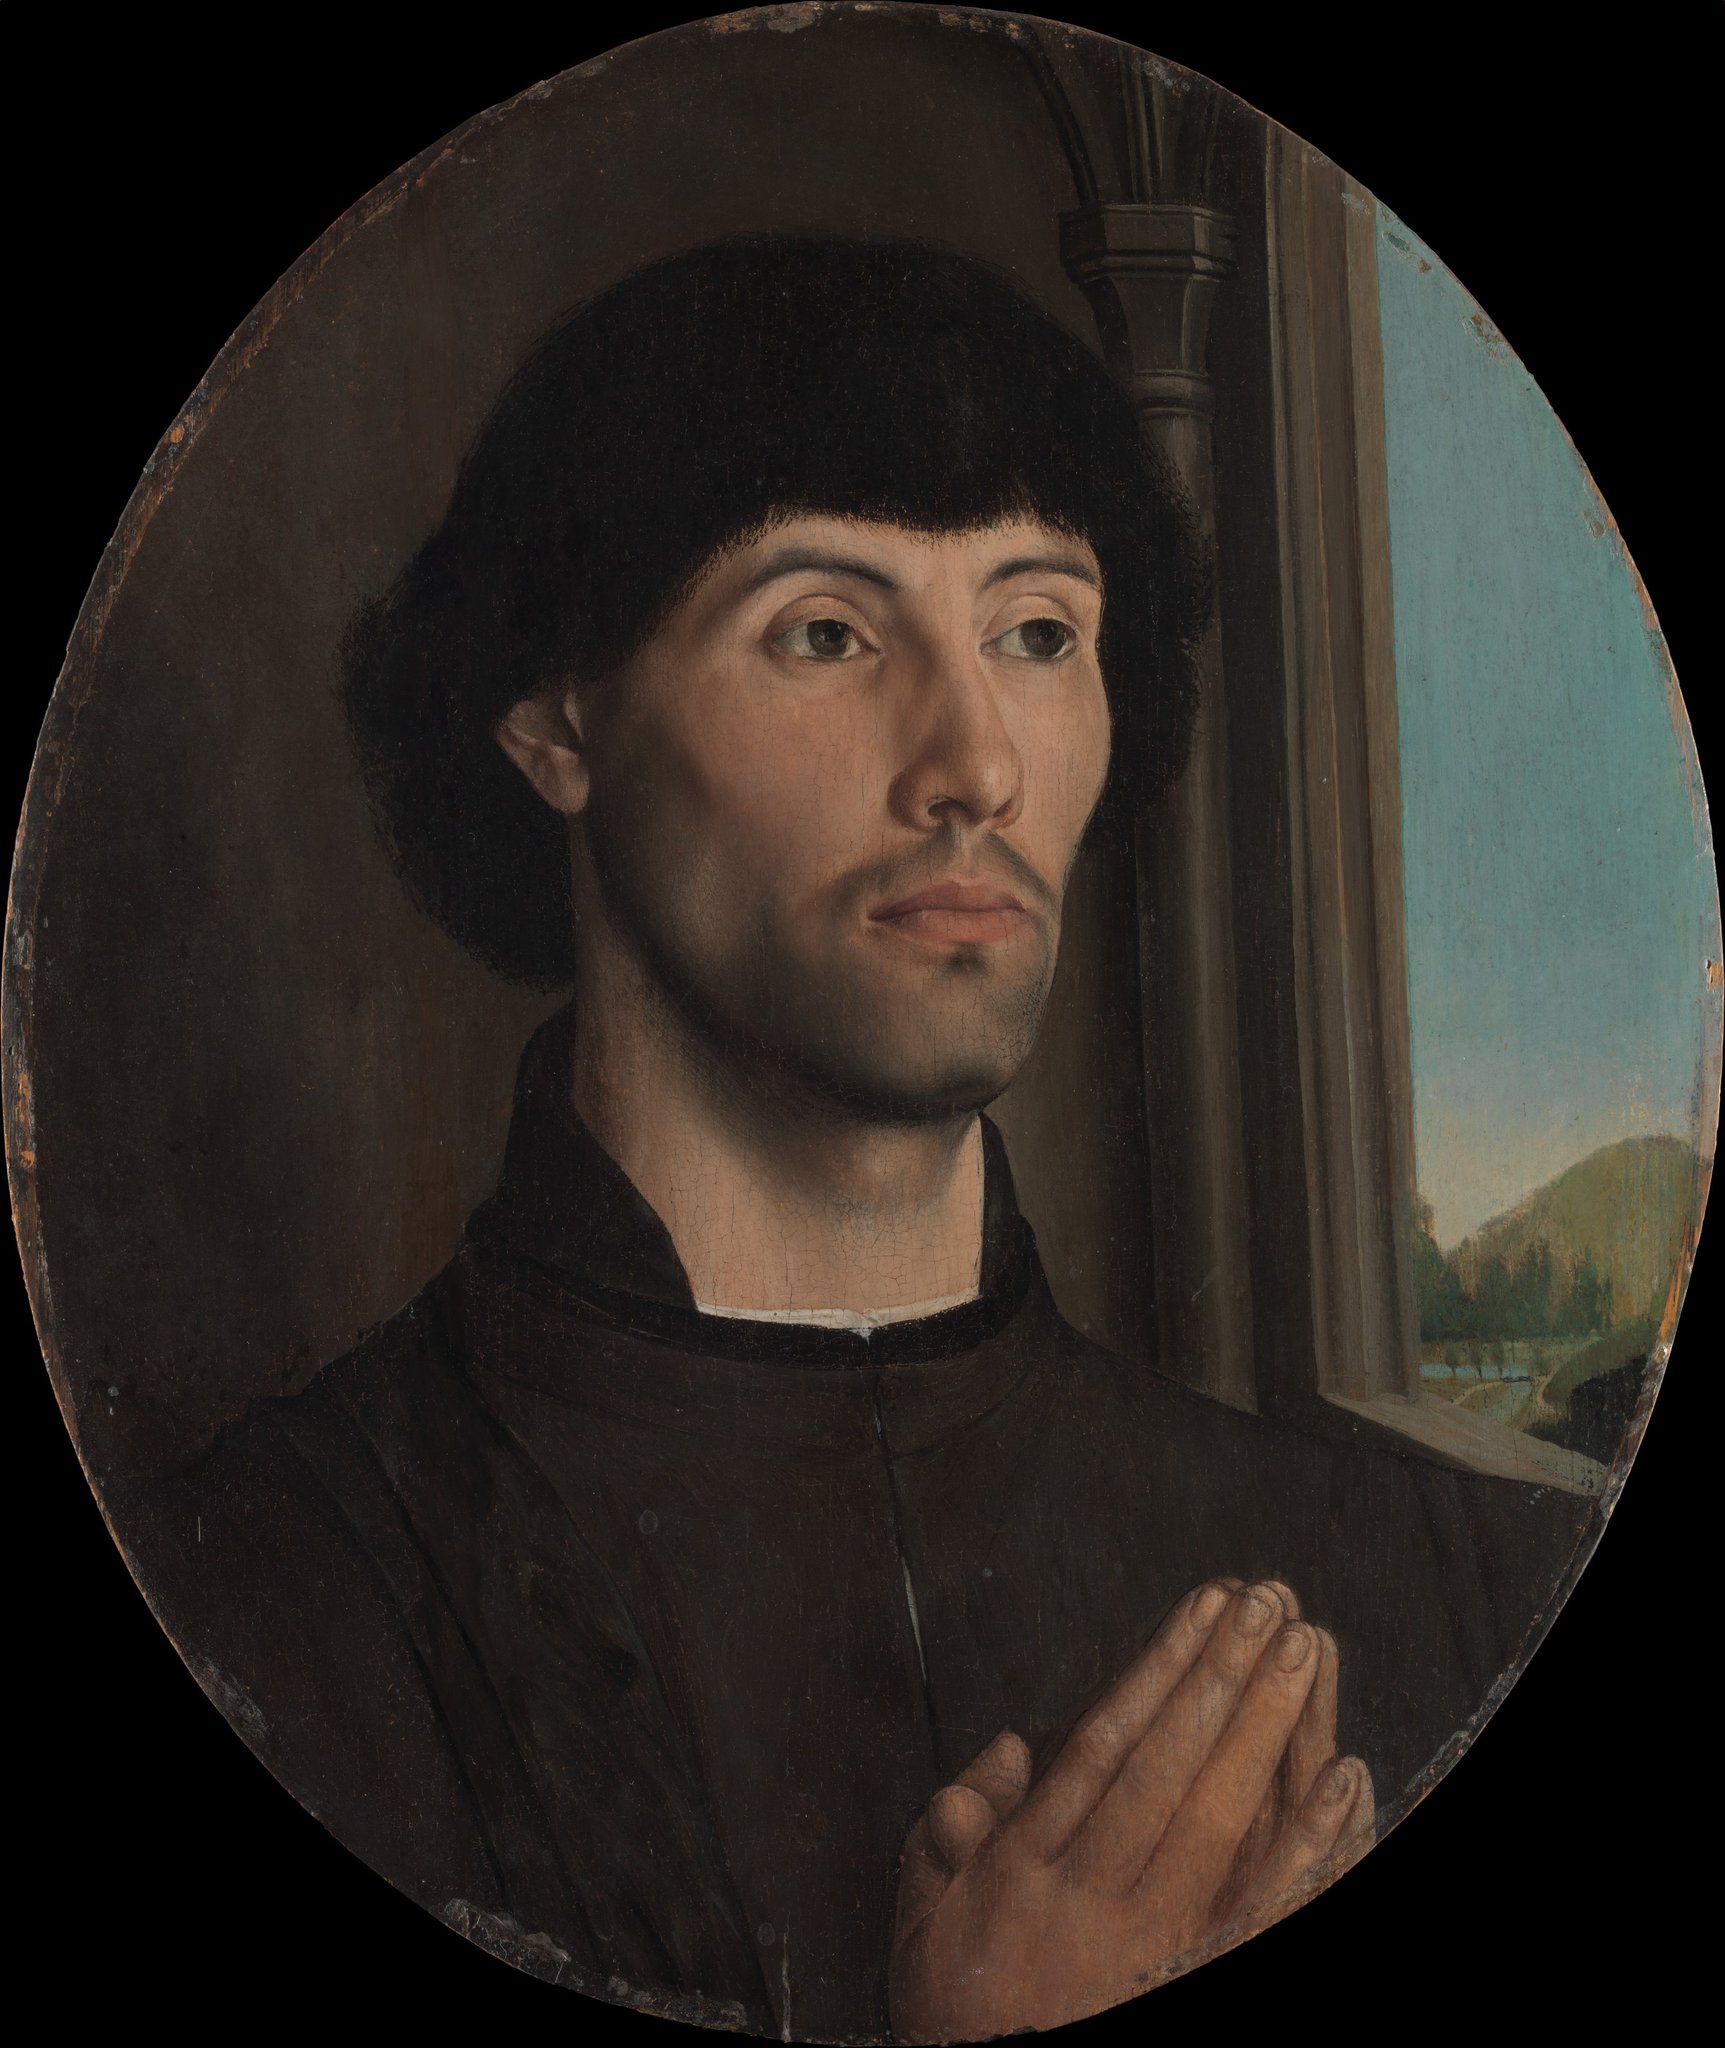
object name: painting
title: Portrait of a Man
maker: hugo van der goes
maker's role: artist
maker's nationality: netherlandish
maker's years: 1467-1482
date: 1475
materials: oil, wood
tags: men,portraits